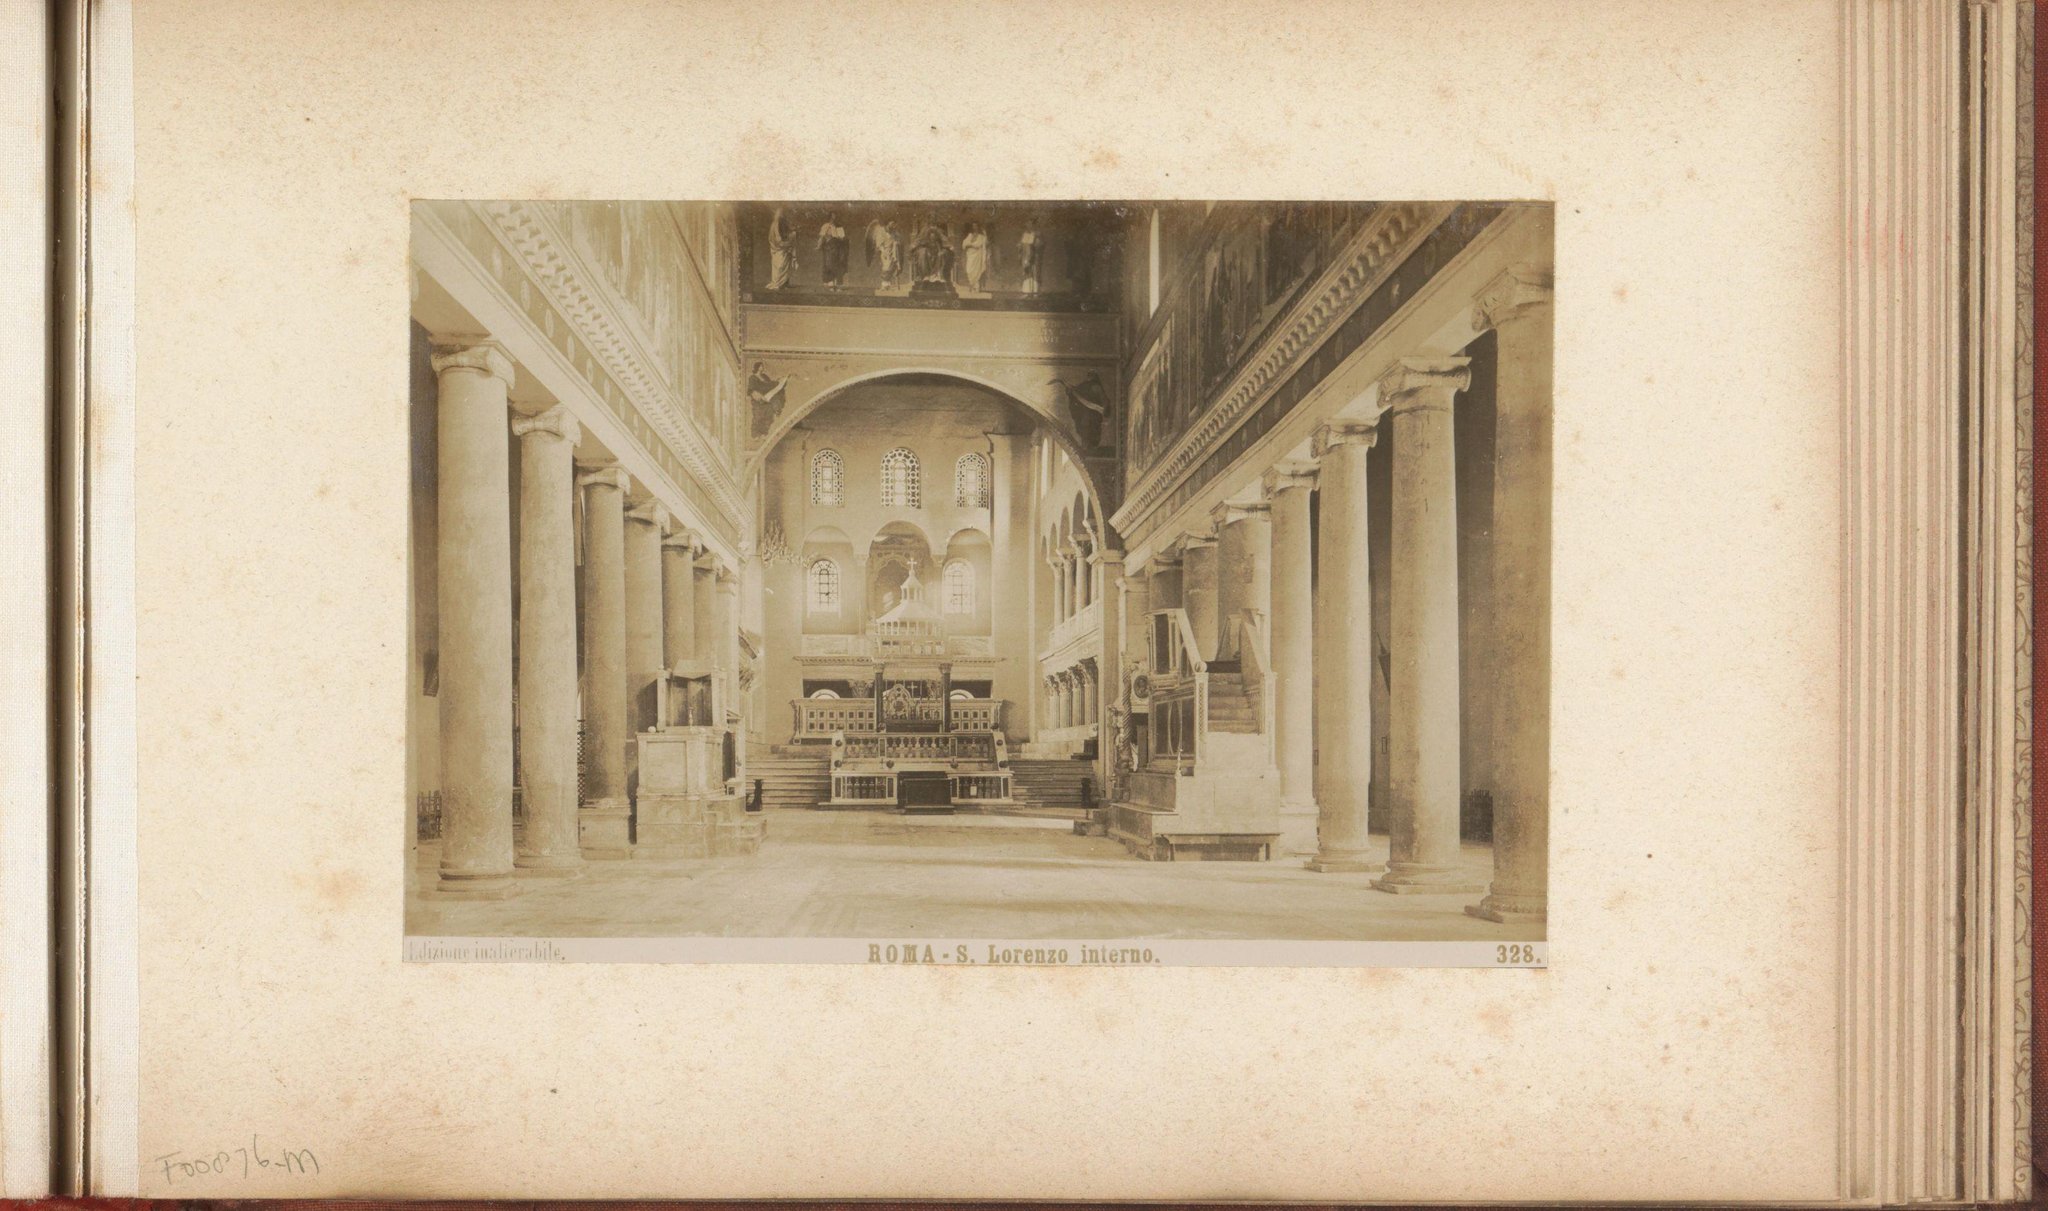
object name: photograph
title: ROMA - S. Lorenzo interno.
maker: Anonymous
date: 1860-1890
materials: cardboard, photographic support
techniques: gelatin silver print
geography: sint-laurens buiten de muren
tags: parts of church interior: nave, interior of church, pulpit, ambo, chancel, altar, rome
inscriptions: number: ‘328’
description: Onderdeel van Fotoalbum met opnames van kerken, beelden en antieke gebouwen in Rome.